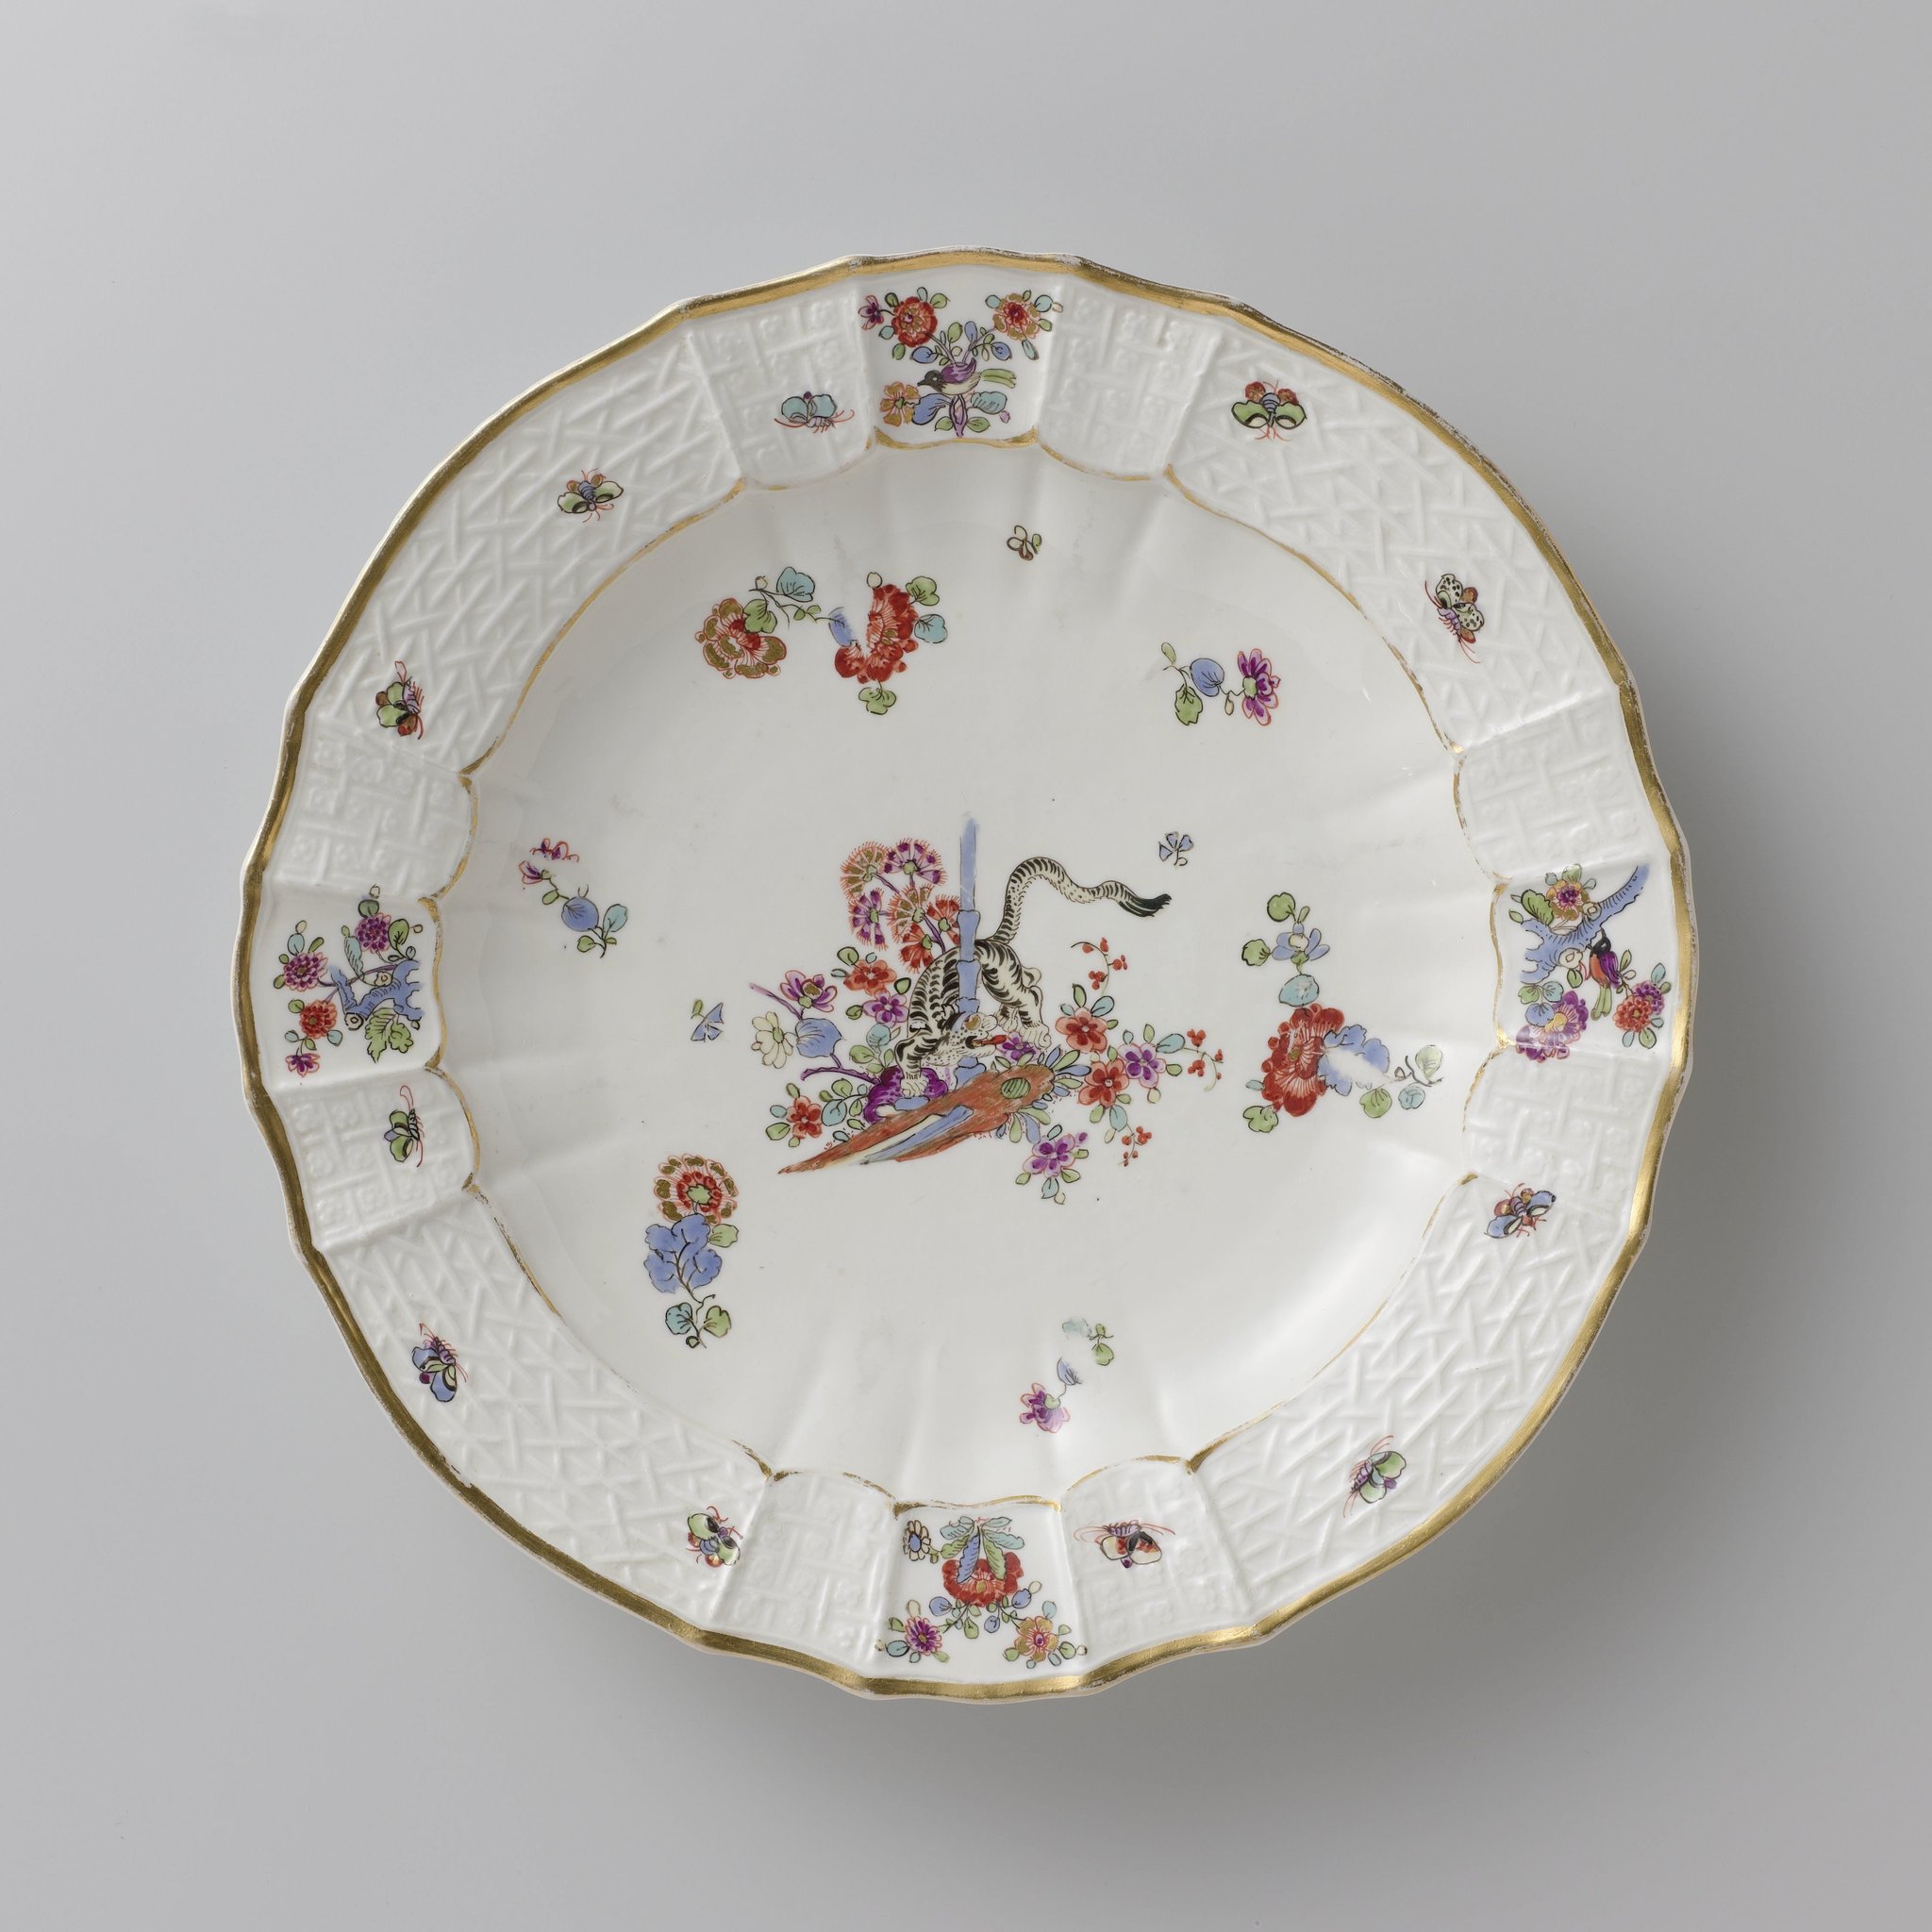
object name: plate dish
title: Rond bord, veelkleurig beschilderd met een Kakiemon-decor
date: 1740-1745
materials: porcelain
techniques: painted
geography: meissen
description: Rond bord van beschilderd porselein. Het bord is geribd en heeft een geschulpte rand. Het bord is beschilderd met een tijger die om een blauwe bamboestengel tussen bloemen is gedraaid, gestrooide Indianische Blumen, vlinders en takken waarop vogels. De rand is versierd met het 'Altbrandenstein'-patroon. Het bord is gemerkt.